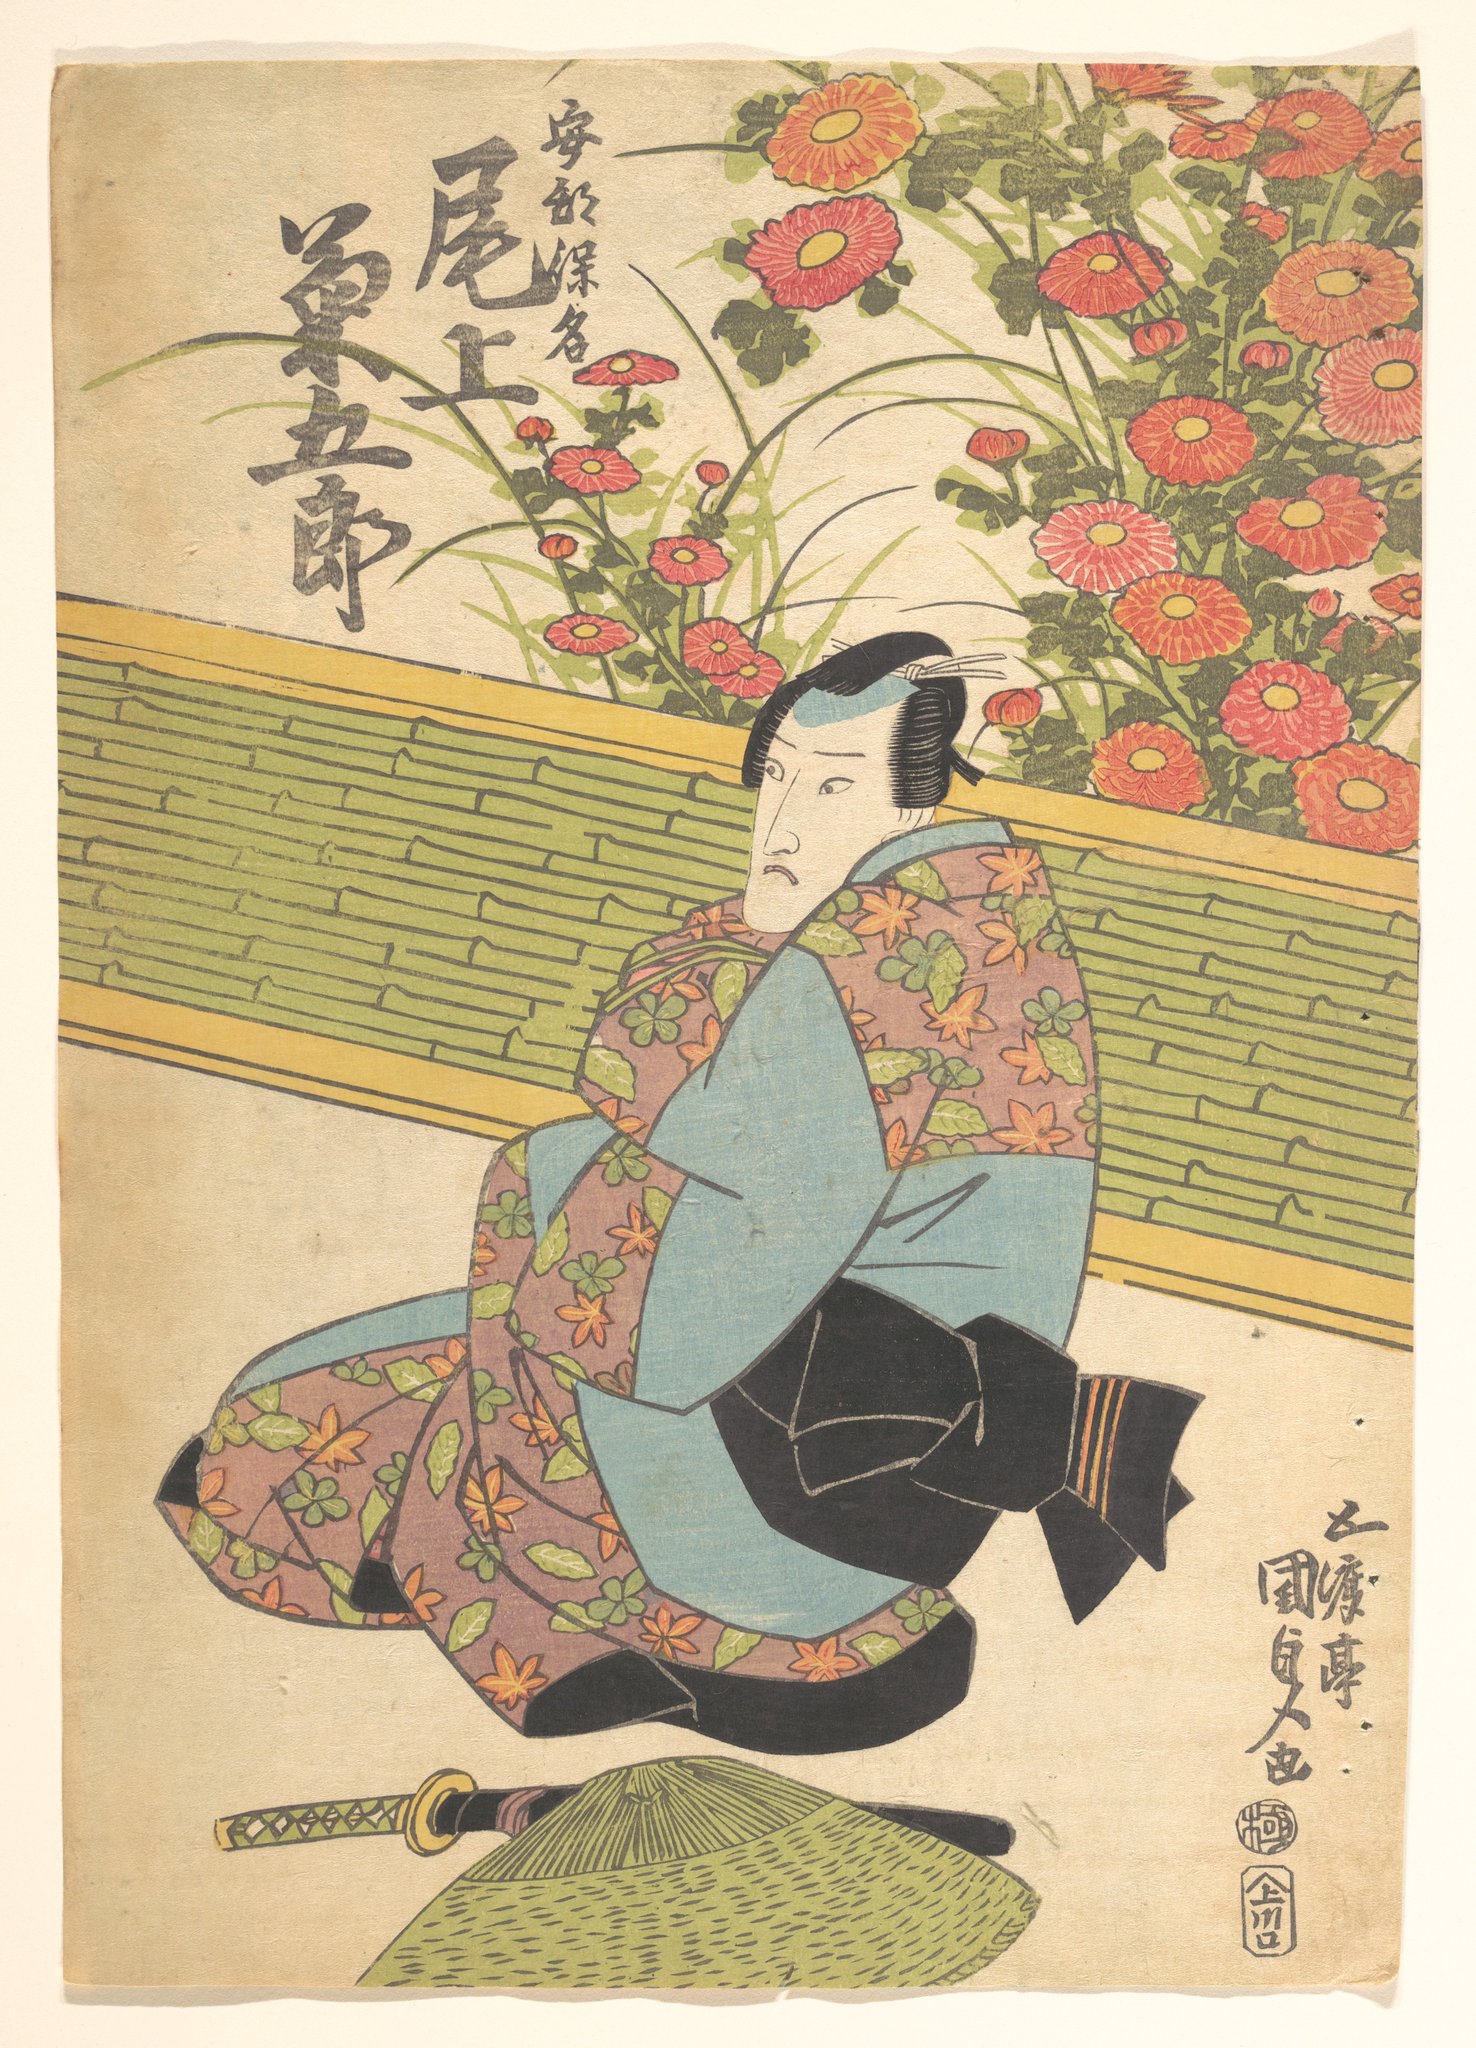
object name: print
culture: japanese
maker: utagawa kunisada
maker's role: artist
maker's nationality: japanese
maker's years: 1786-1864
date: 1801-1900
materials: ink, paper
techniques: woodblock print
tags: men,flowers